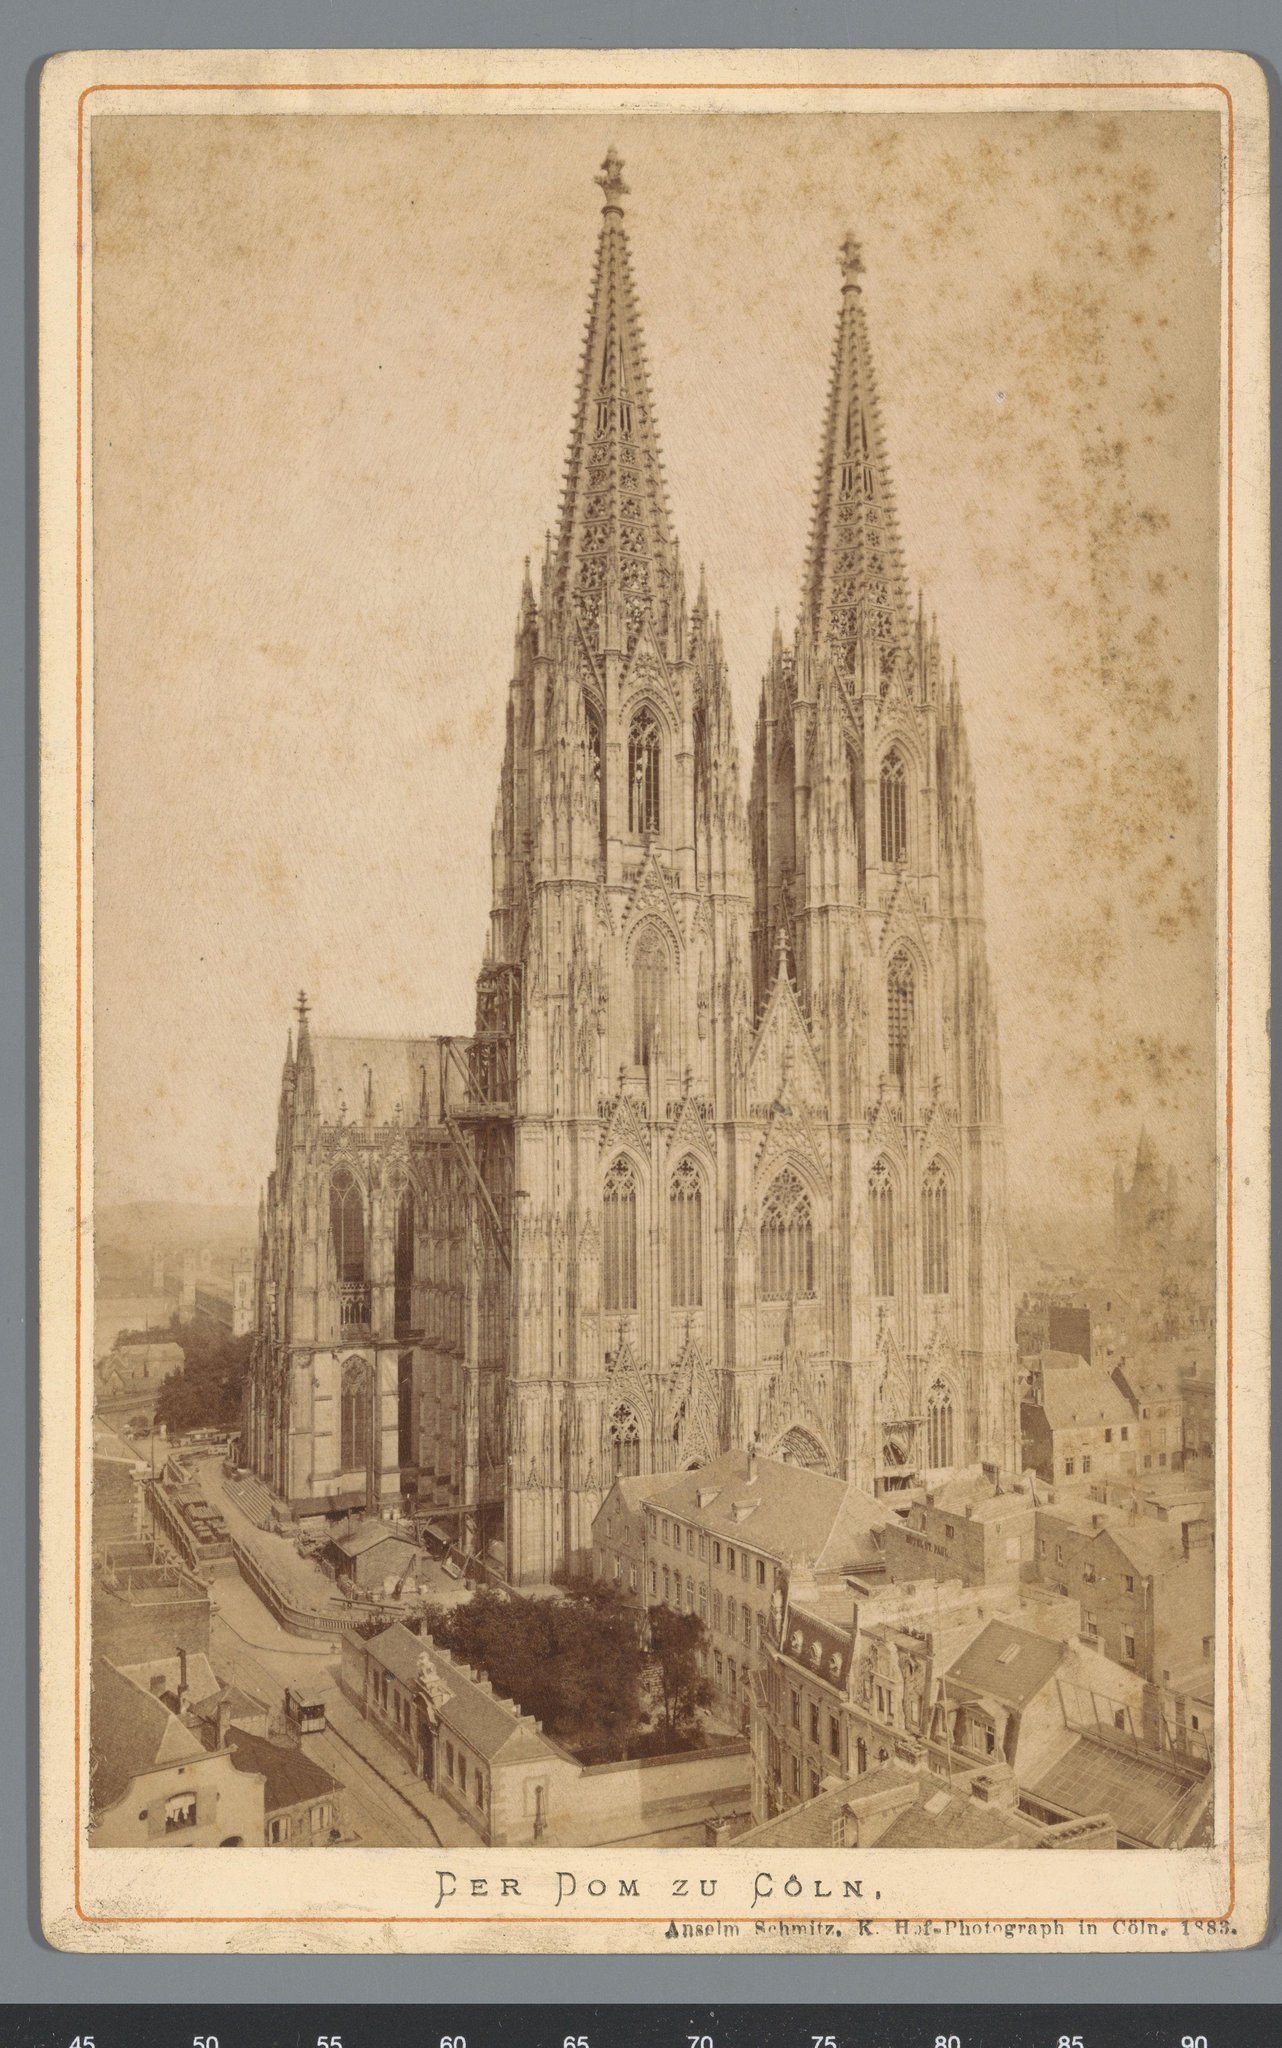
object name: cabinet photograph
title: Der Dom zu Coln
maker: anselm schmitz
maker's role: publisher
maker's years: 1831-1903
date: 1883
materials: cardboard, photographic support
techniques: albumen print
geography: cologne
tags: dome ~ architecture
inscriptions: date